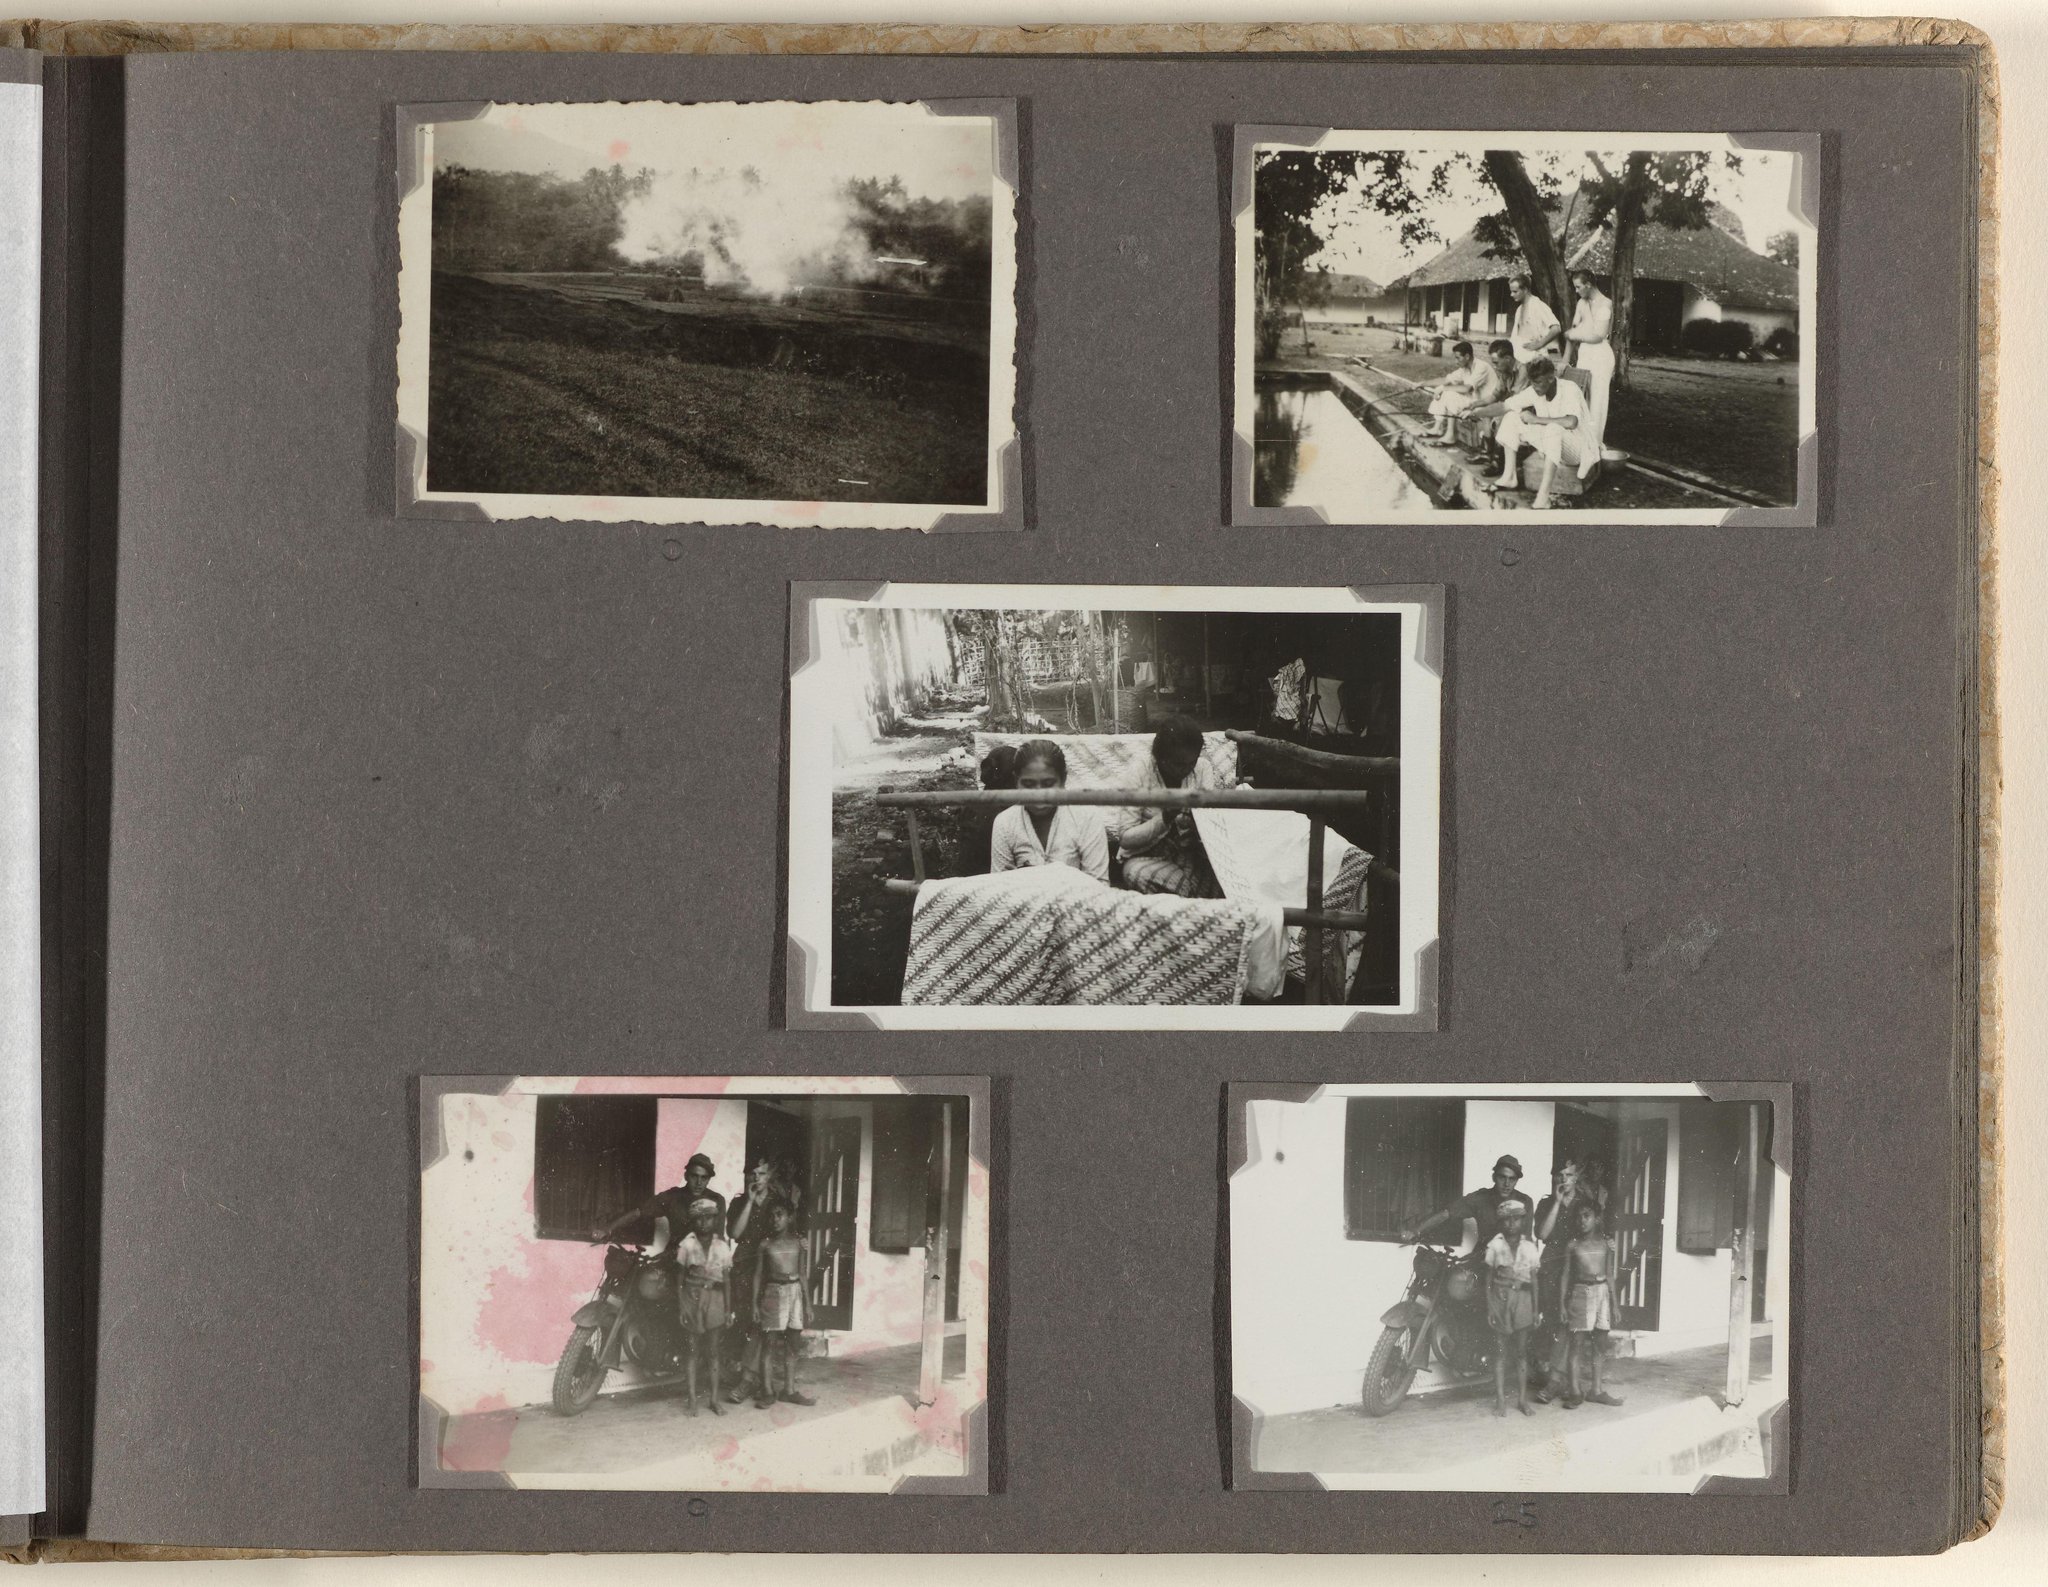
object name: album leaf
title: Diverse onderwerpen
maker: Anonymous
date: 1946-1949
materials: cardboard, photographic support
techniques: gelatin silver print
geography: dutch east indies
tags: colonial system, military service, dyeing of cloth with pattern; batik-work, modern forms of military vehicles, the soldier off duty, dutch east indies, the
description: Albumblad met vijf foto's: landschap, vissende militairen, batikkende vrouwen en Nederlandse militairen met motor en Indonesische kinderen. Onderdeel van het fotoalbum over de diensttijd van Nederlandse militairen in Nederlands-Indië, ca. 1946-1949.